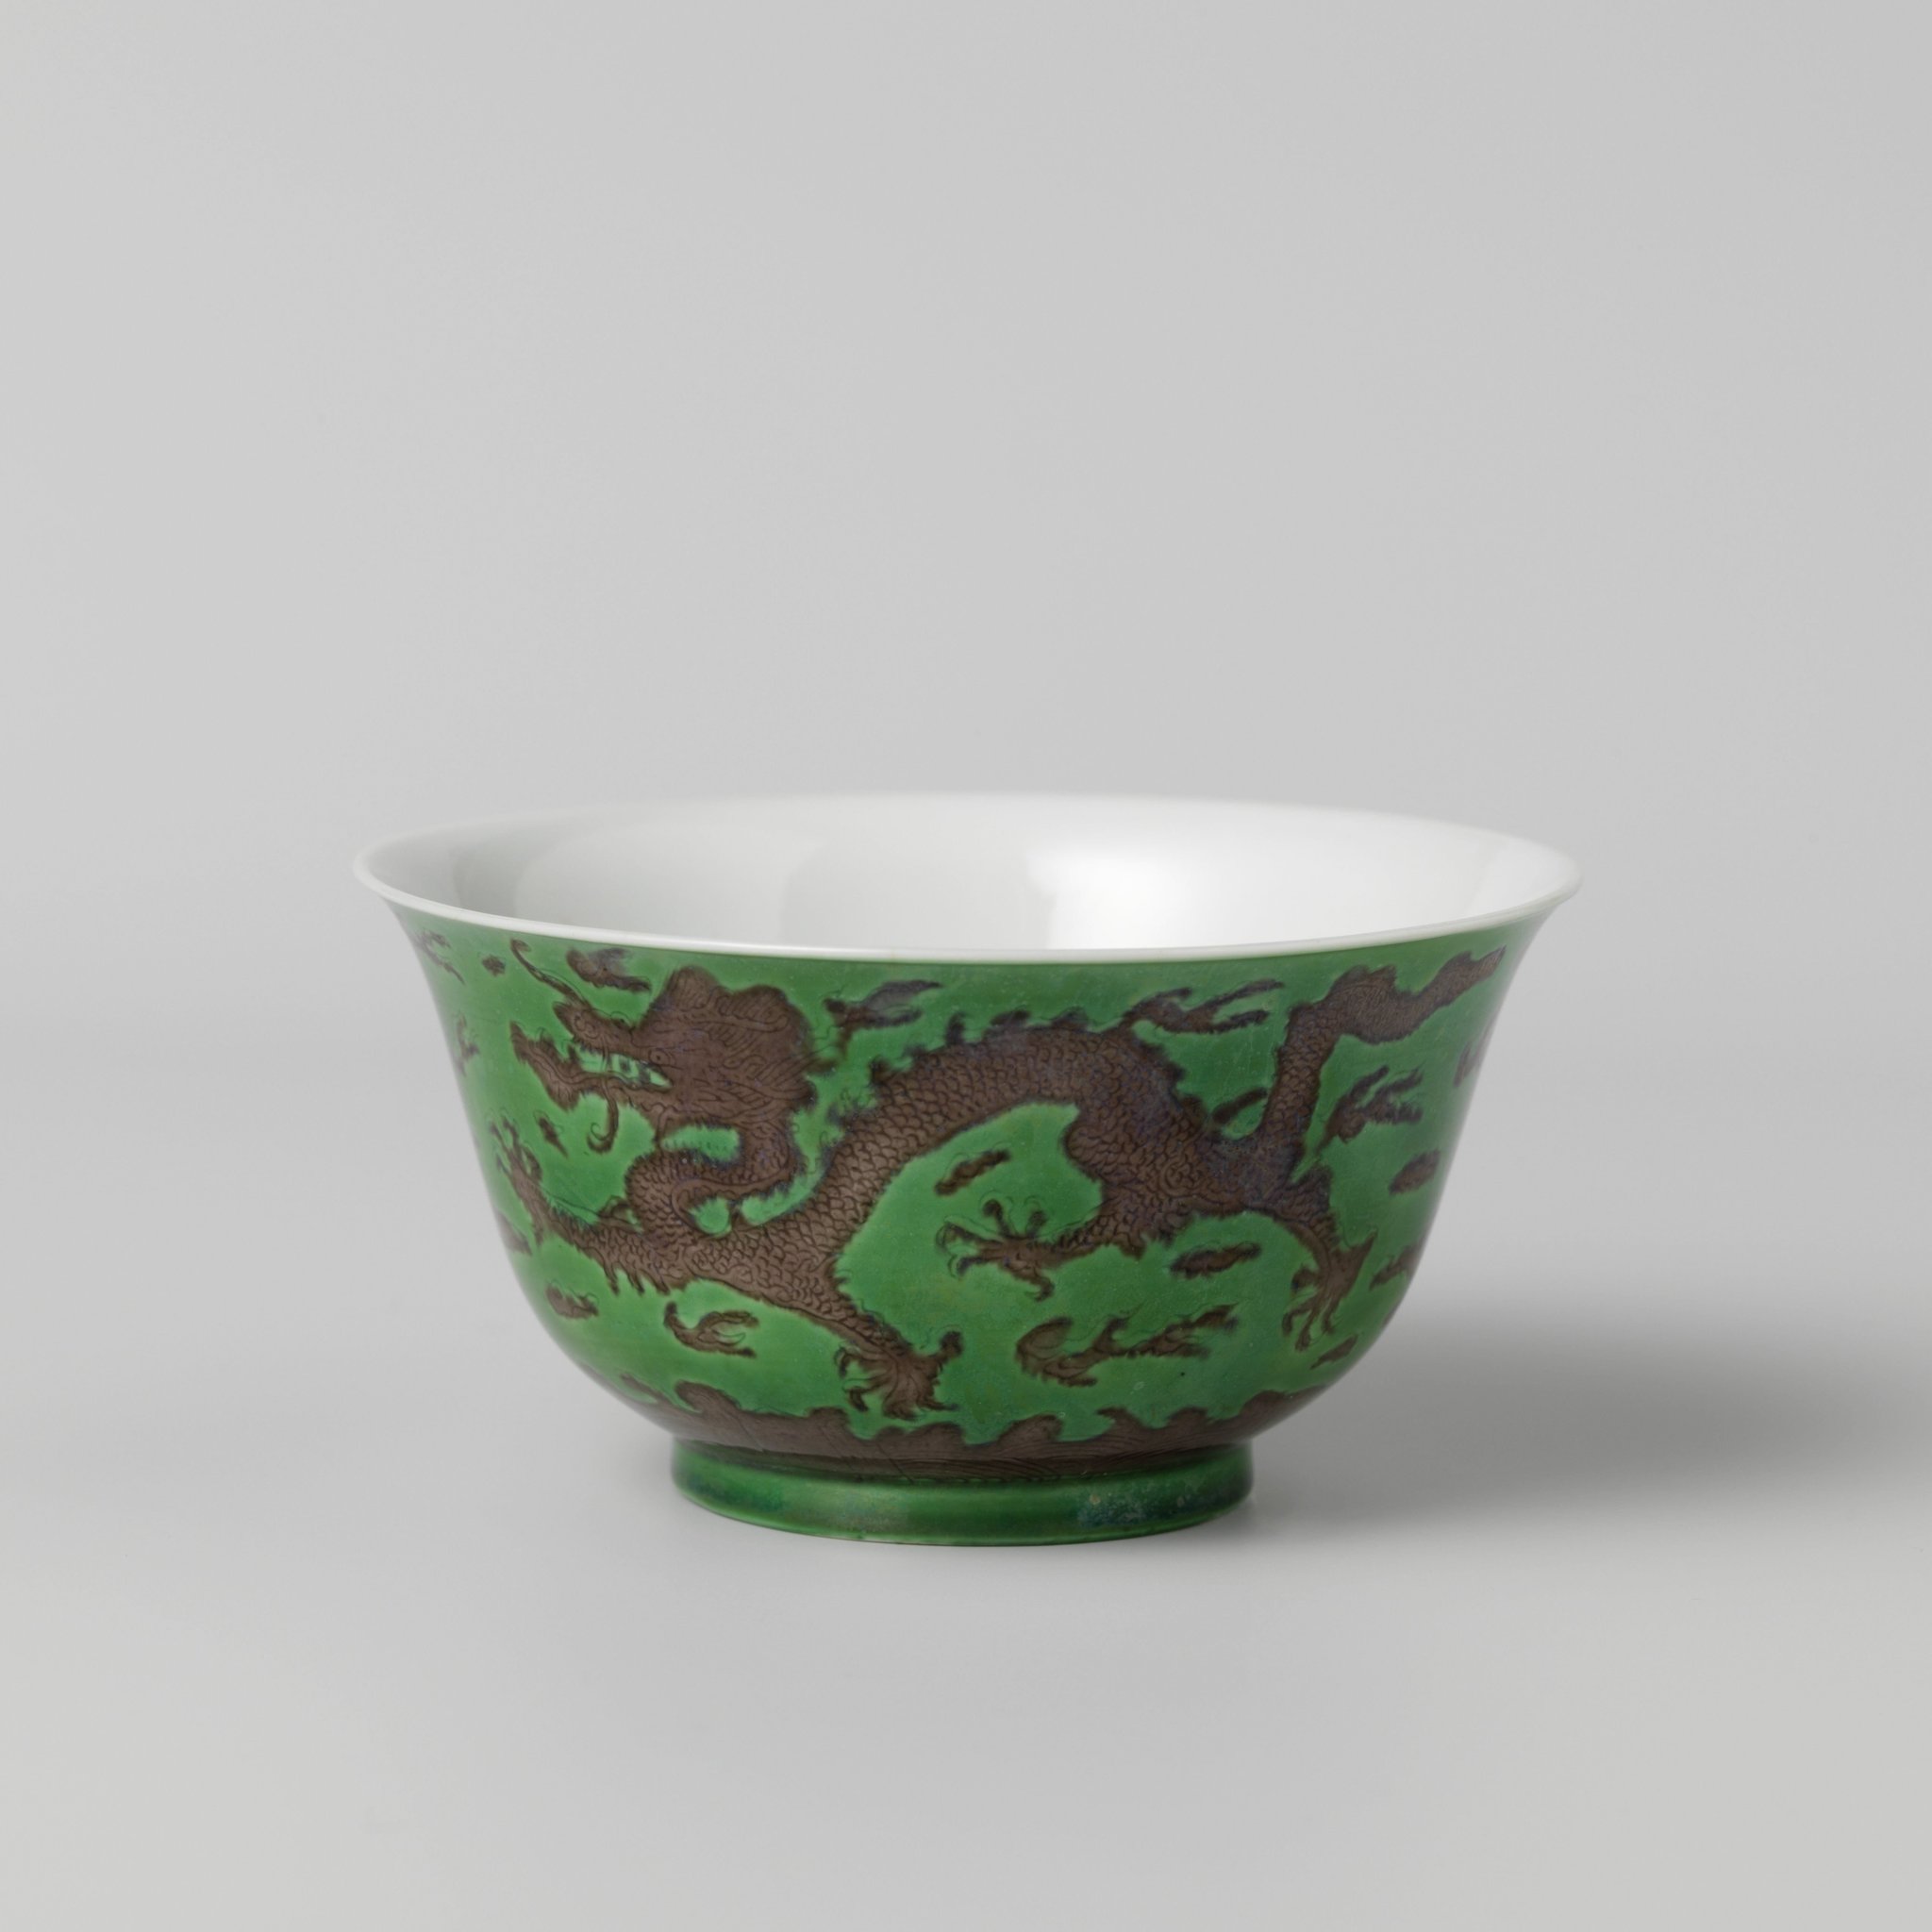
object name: bowl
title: Bowl with pearl chasing dragons on a green ground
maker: Anonymous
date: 1680-1720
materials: cobalt, glaze, paint, porcelain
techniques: firing, turning, vitrification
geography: china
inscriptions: mark: ‘大 清 康 熙 年 製 dà qīng Kāng xī nián zhì’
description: Kom van porselein met spreidende rand, beschilderd in onderglazuur blauw en op het glazuur groen en aubergine. Op de wand twee parel najagende vijfklauwige draken in reserve tegen een groene grond; rond de voet in reserve een golf-patroon. Gemerkt op de onderzijde met het zes-karaktermerk van keizer Kangxi in een dubbele cirkel. Famille verte.